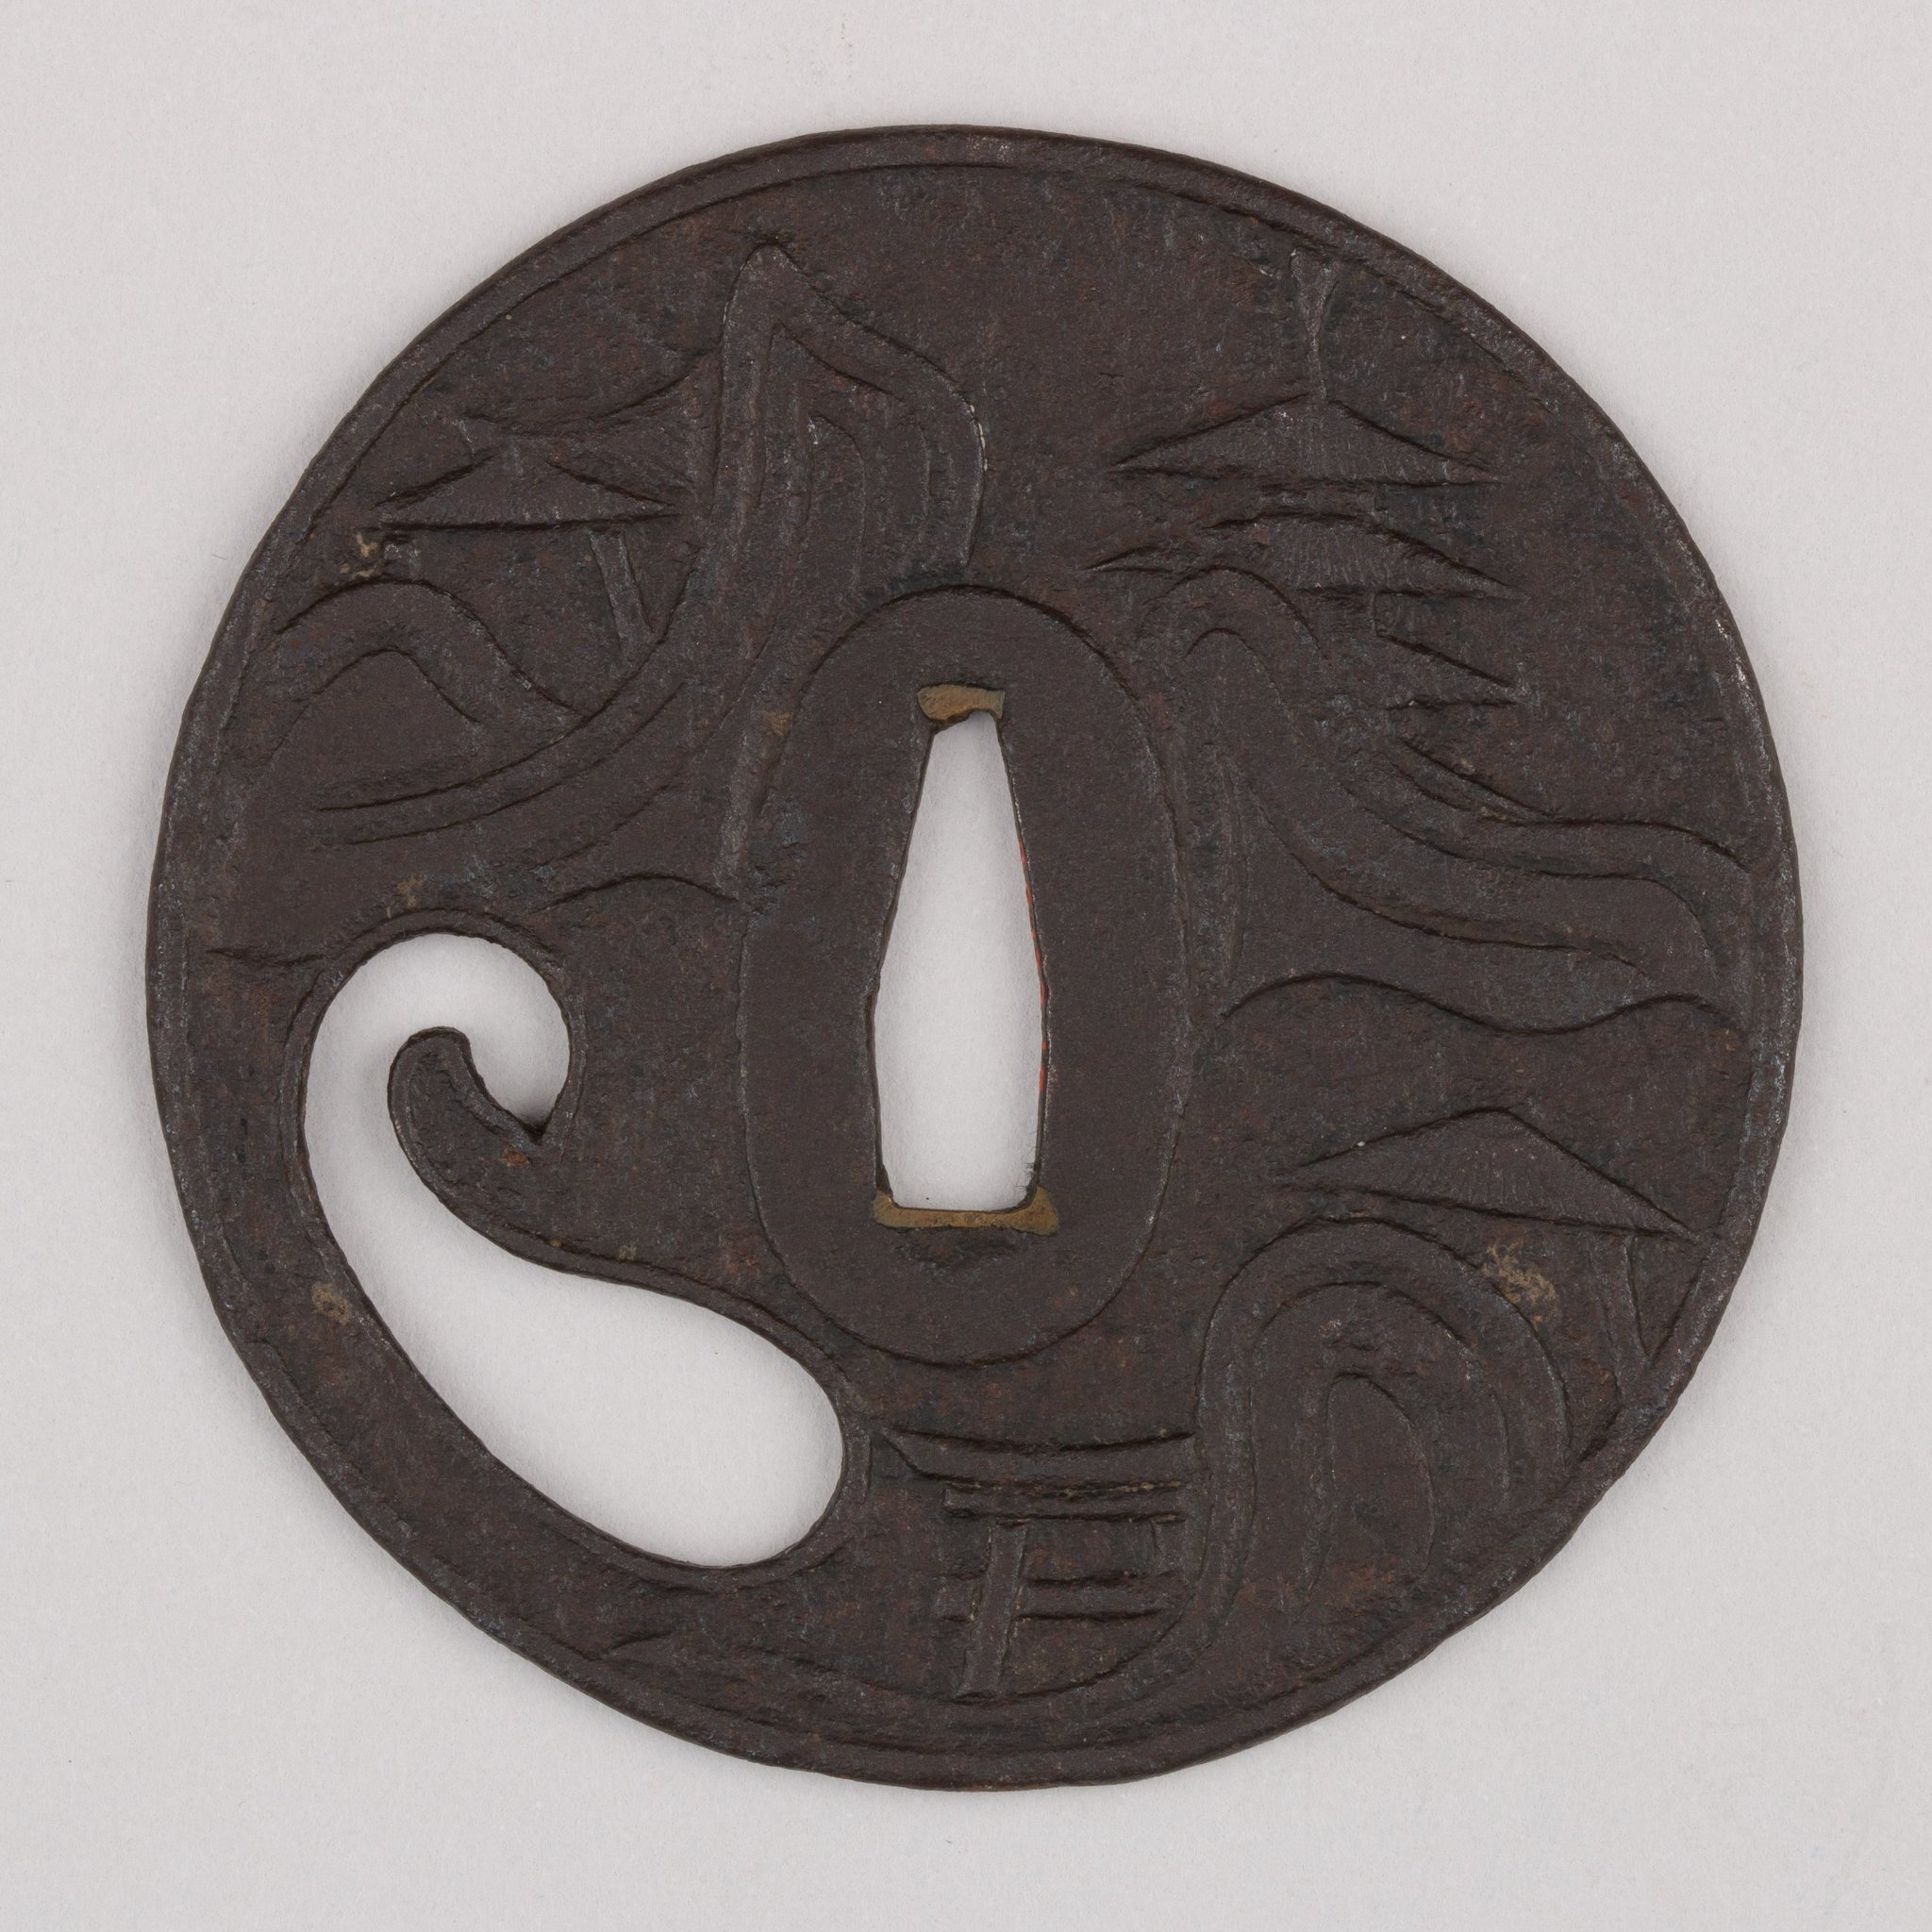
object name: sword guard tsuba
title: Sword Guard (Tsuba)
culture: japanese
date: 1601-1633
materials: copper, iron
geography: japan